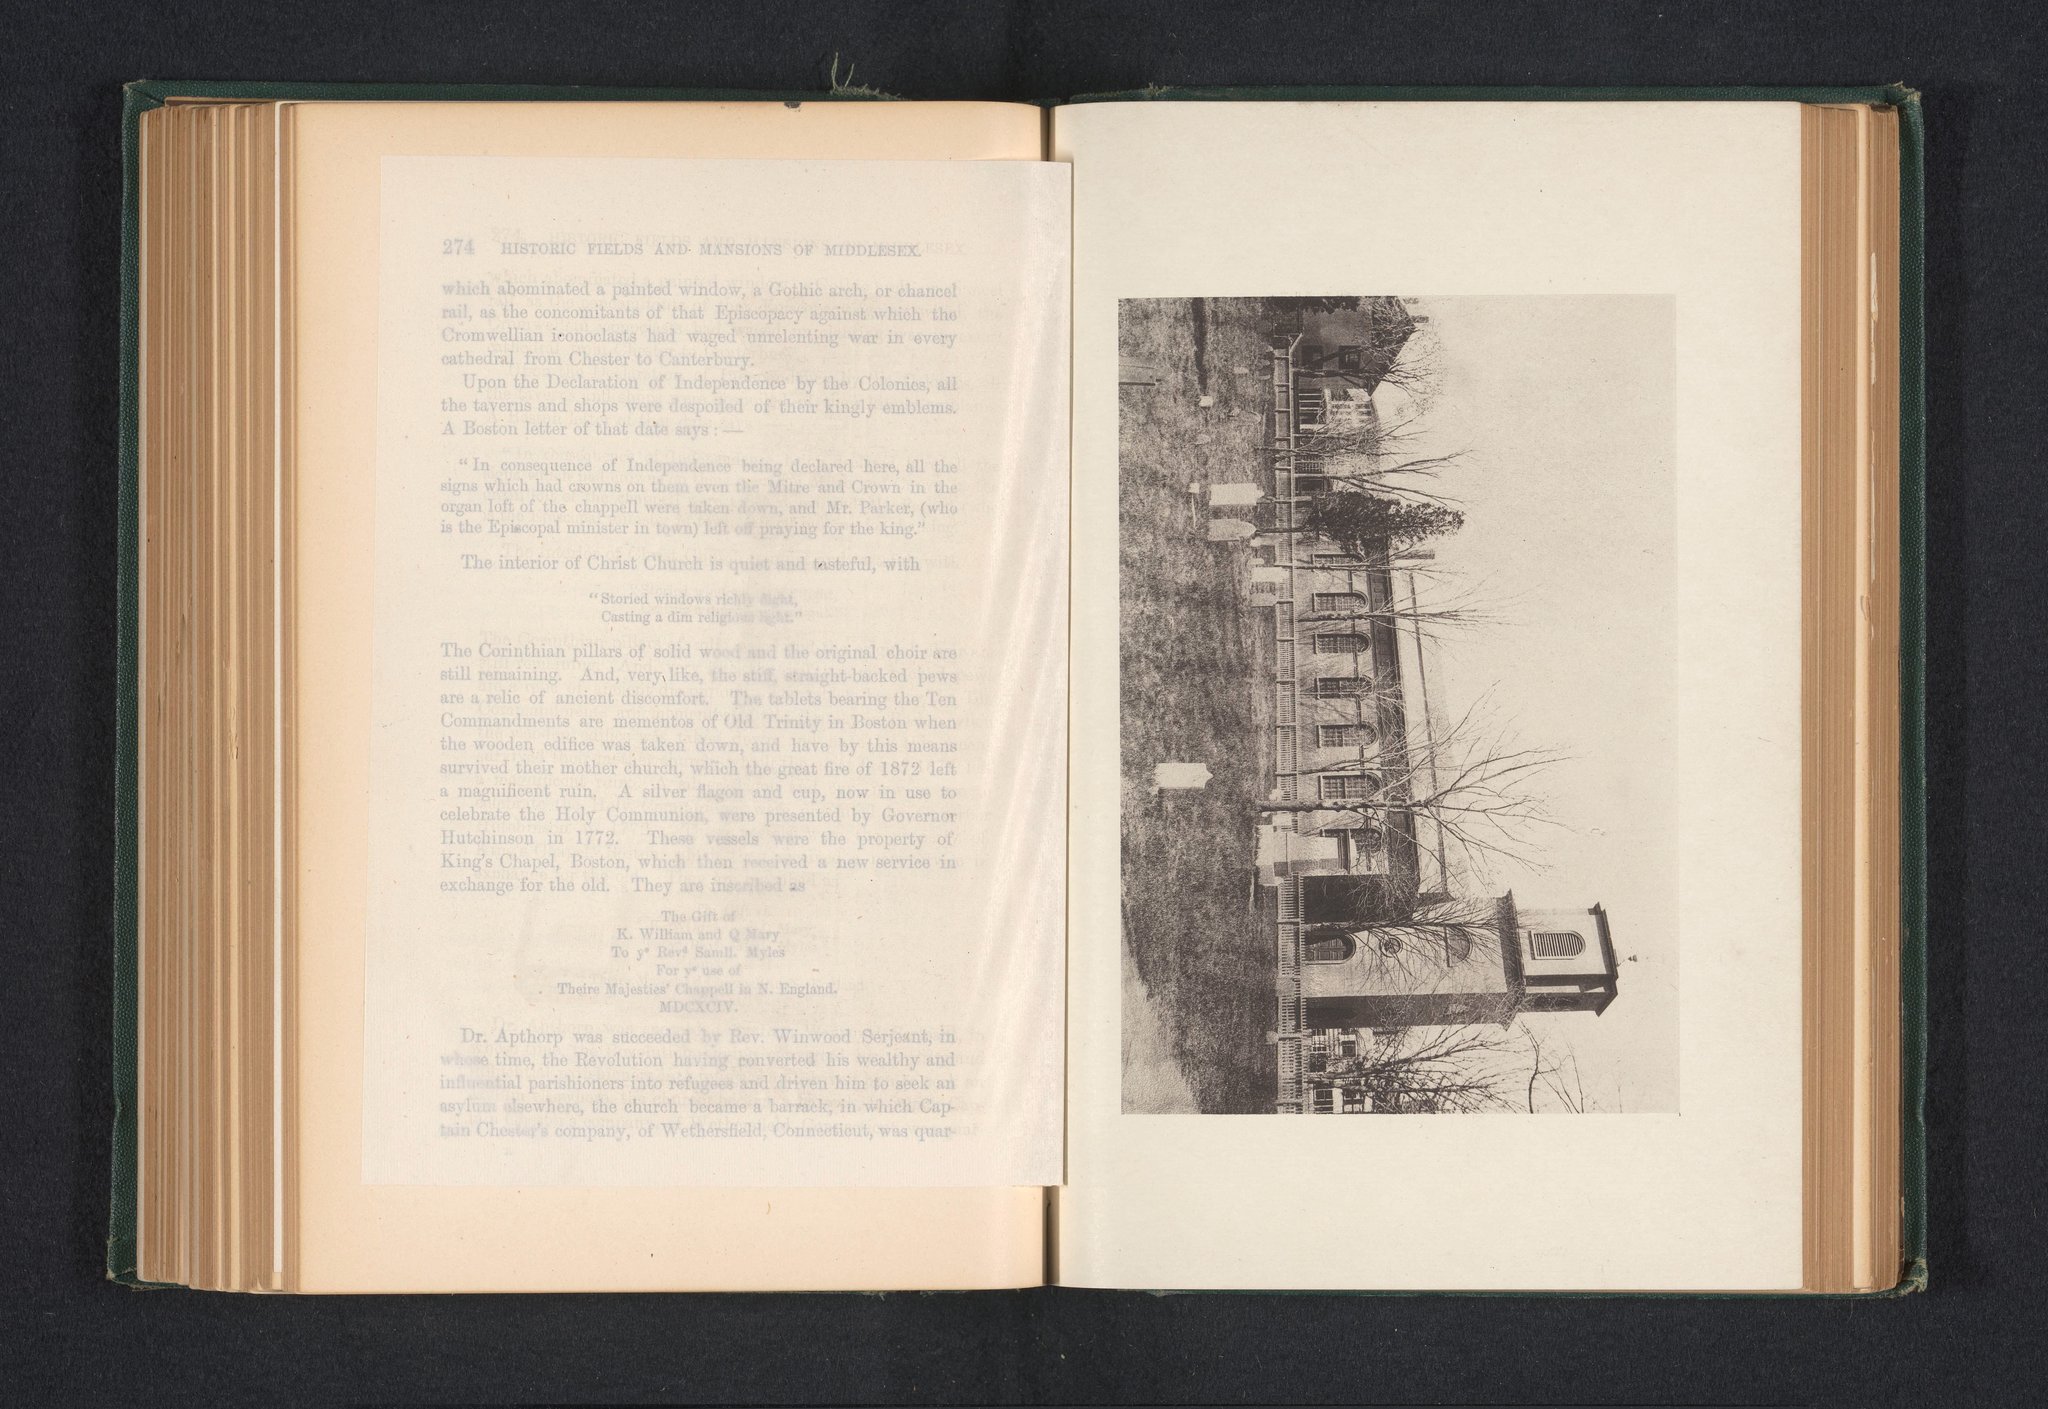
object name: page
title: Gezicht op de Christ Church en de begraafplaats te Cambridge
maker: Anonymous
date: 1869-1874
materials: paper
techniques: photograph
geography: cambridge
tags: church (exterior), churchyard, cemetery